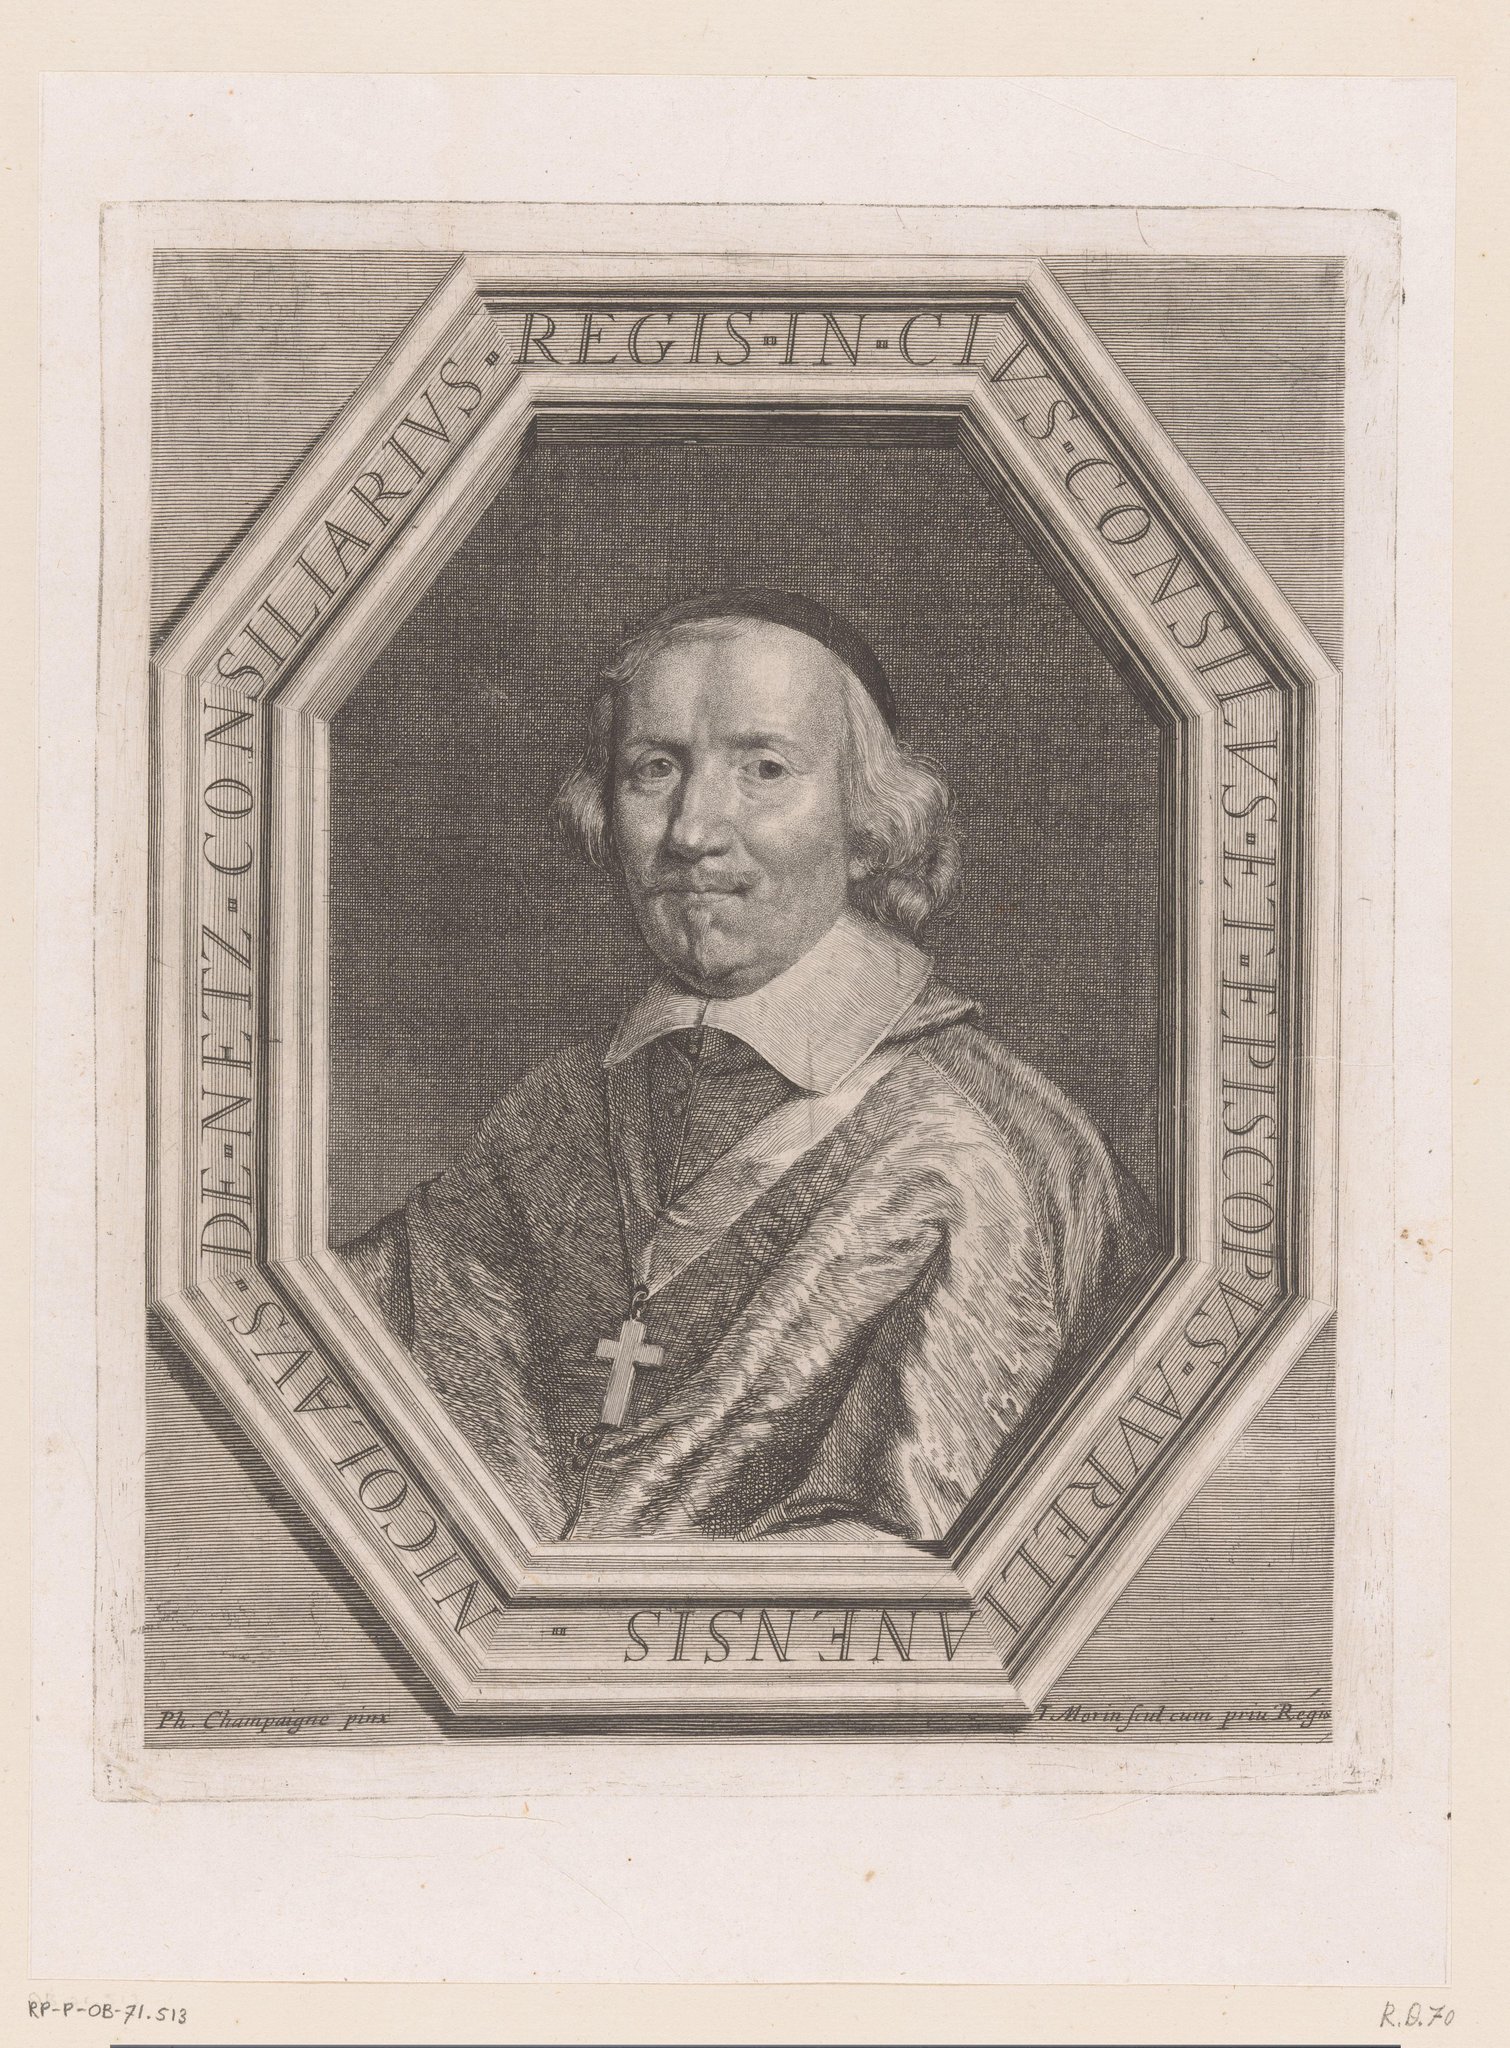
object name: print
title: Portret van Nicolas de Netz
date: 1610-1650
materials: paper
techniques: etching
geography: france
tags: archbishop, bishop, etc. (roman catholic), historical persons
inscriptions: collector's mark: Lugt 2228